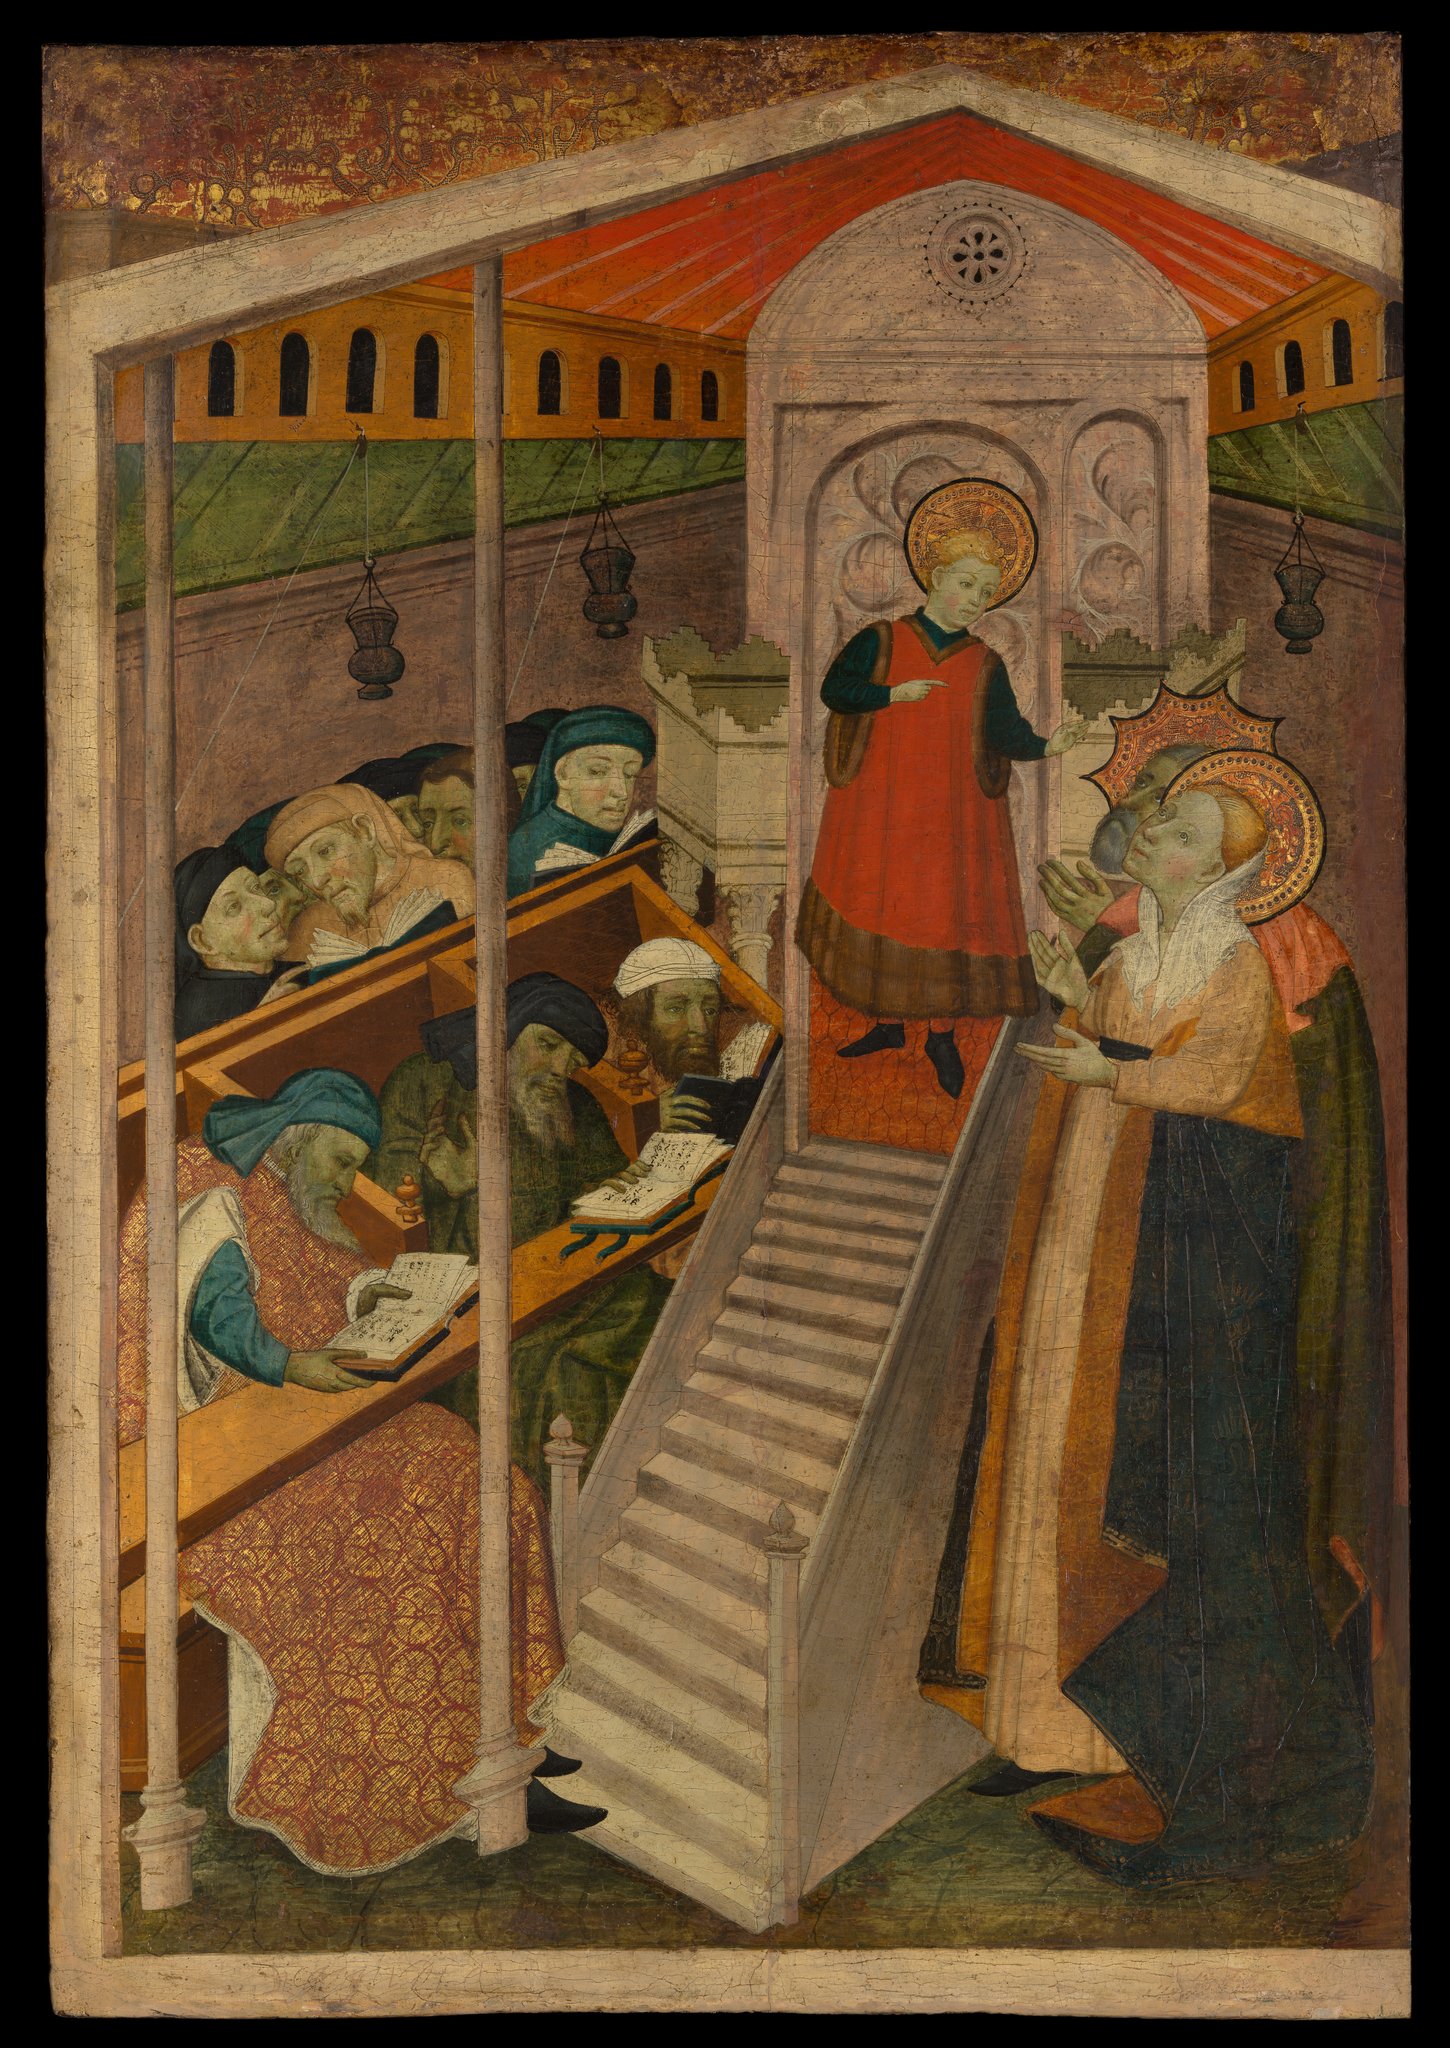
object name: painting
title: Christ among the Doctors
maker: spanish (catalan) painter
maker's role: artist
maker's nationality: spanish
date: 1400-1429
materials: gold, paint, wood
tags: men,women,reading,christ,virgin mary,joseph